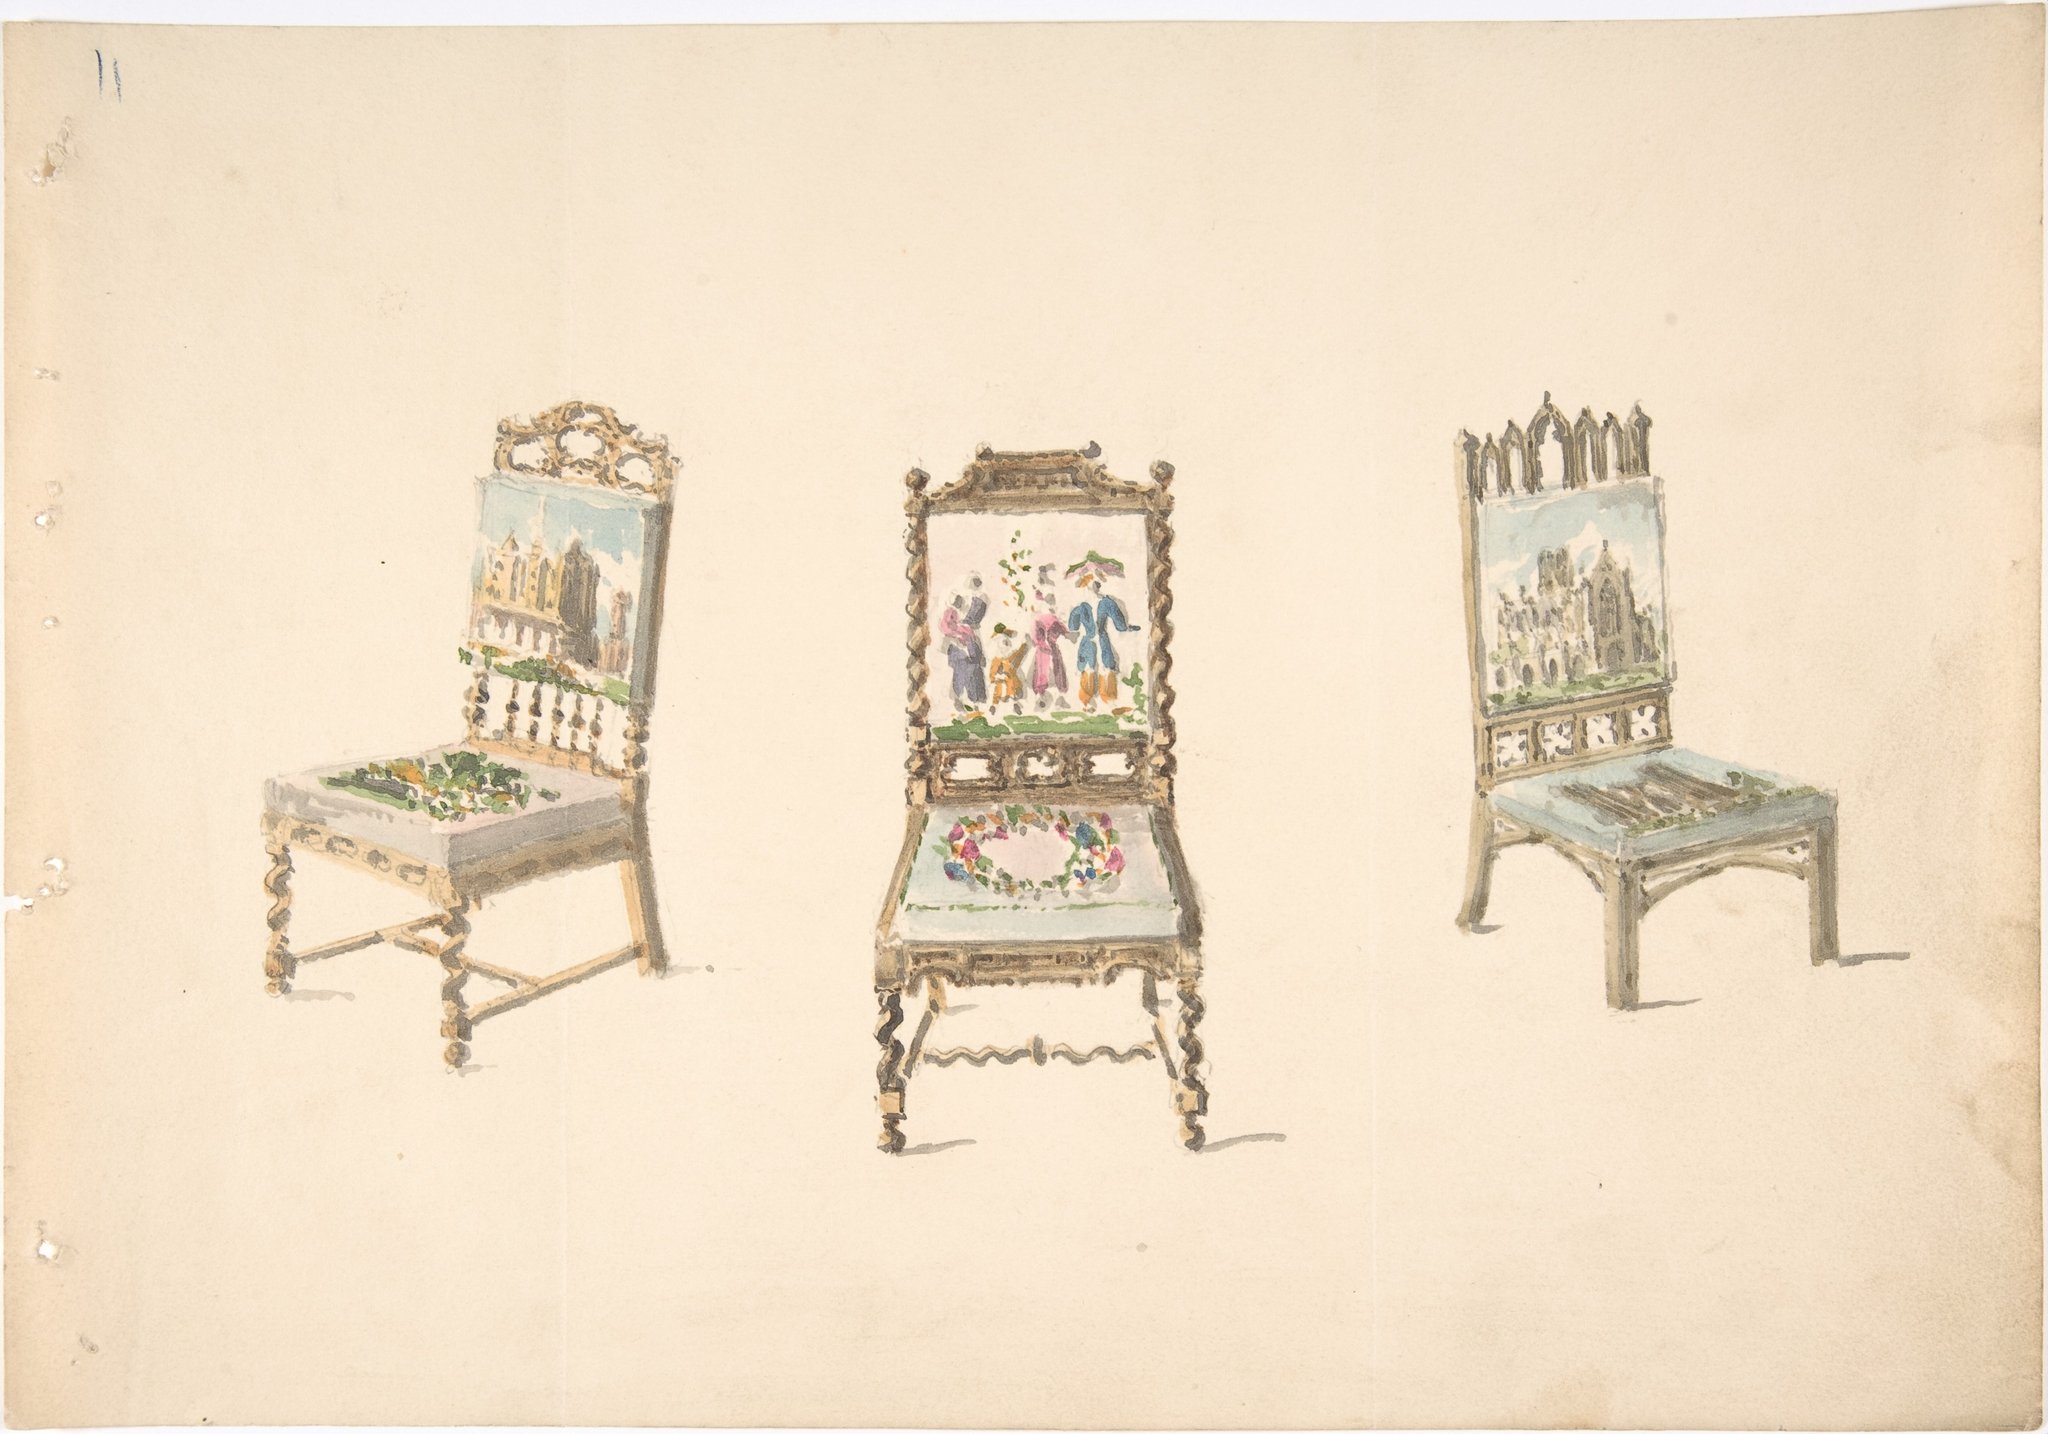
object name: drawing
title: Design for Three Chairs with Pictorial Upholstery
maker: anonymous, british, 19th century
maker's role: artist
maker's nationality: british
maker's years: 1800-1900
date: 1801-1833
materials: ink, watercolor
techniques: brush, pen, wash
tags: chairs